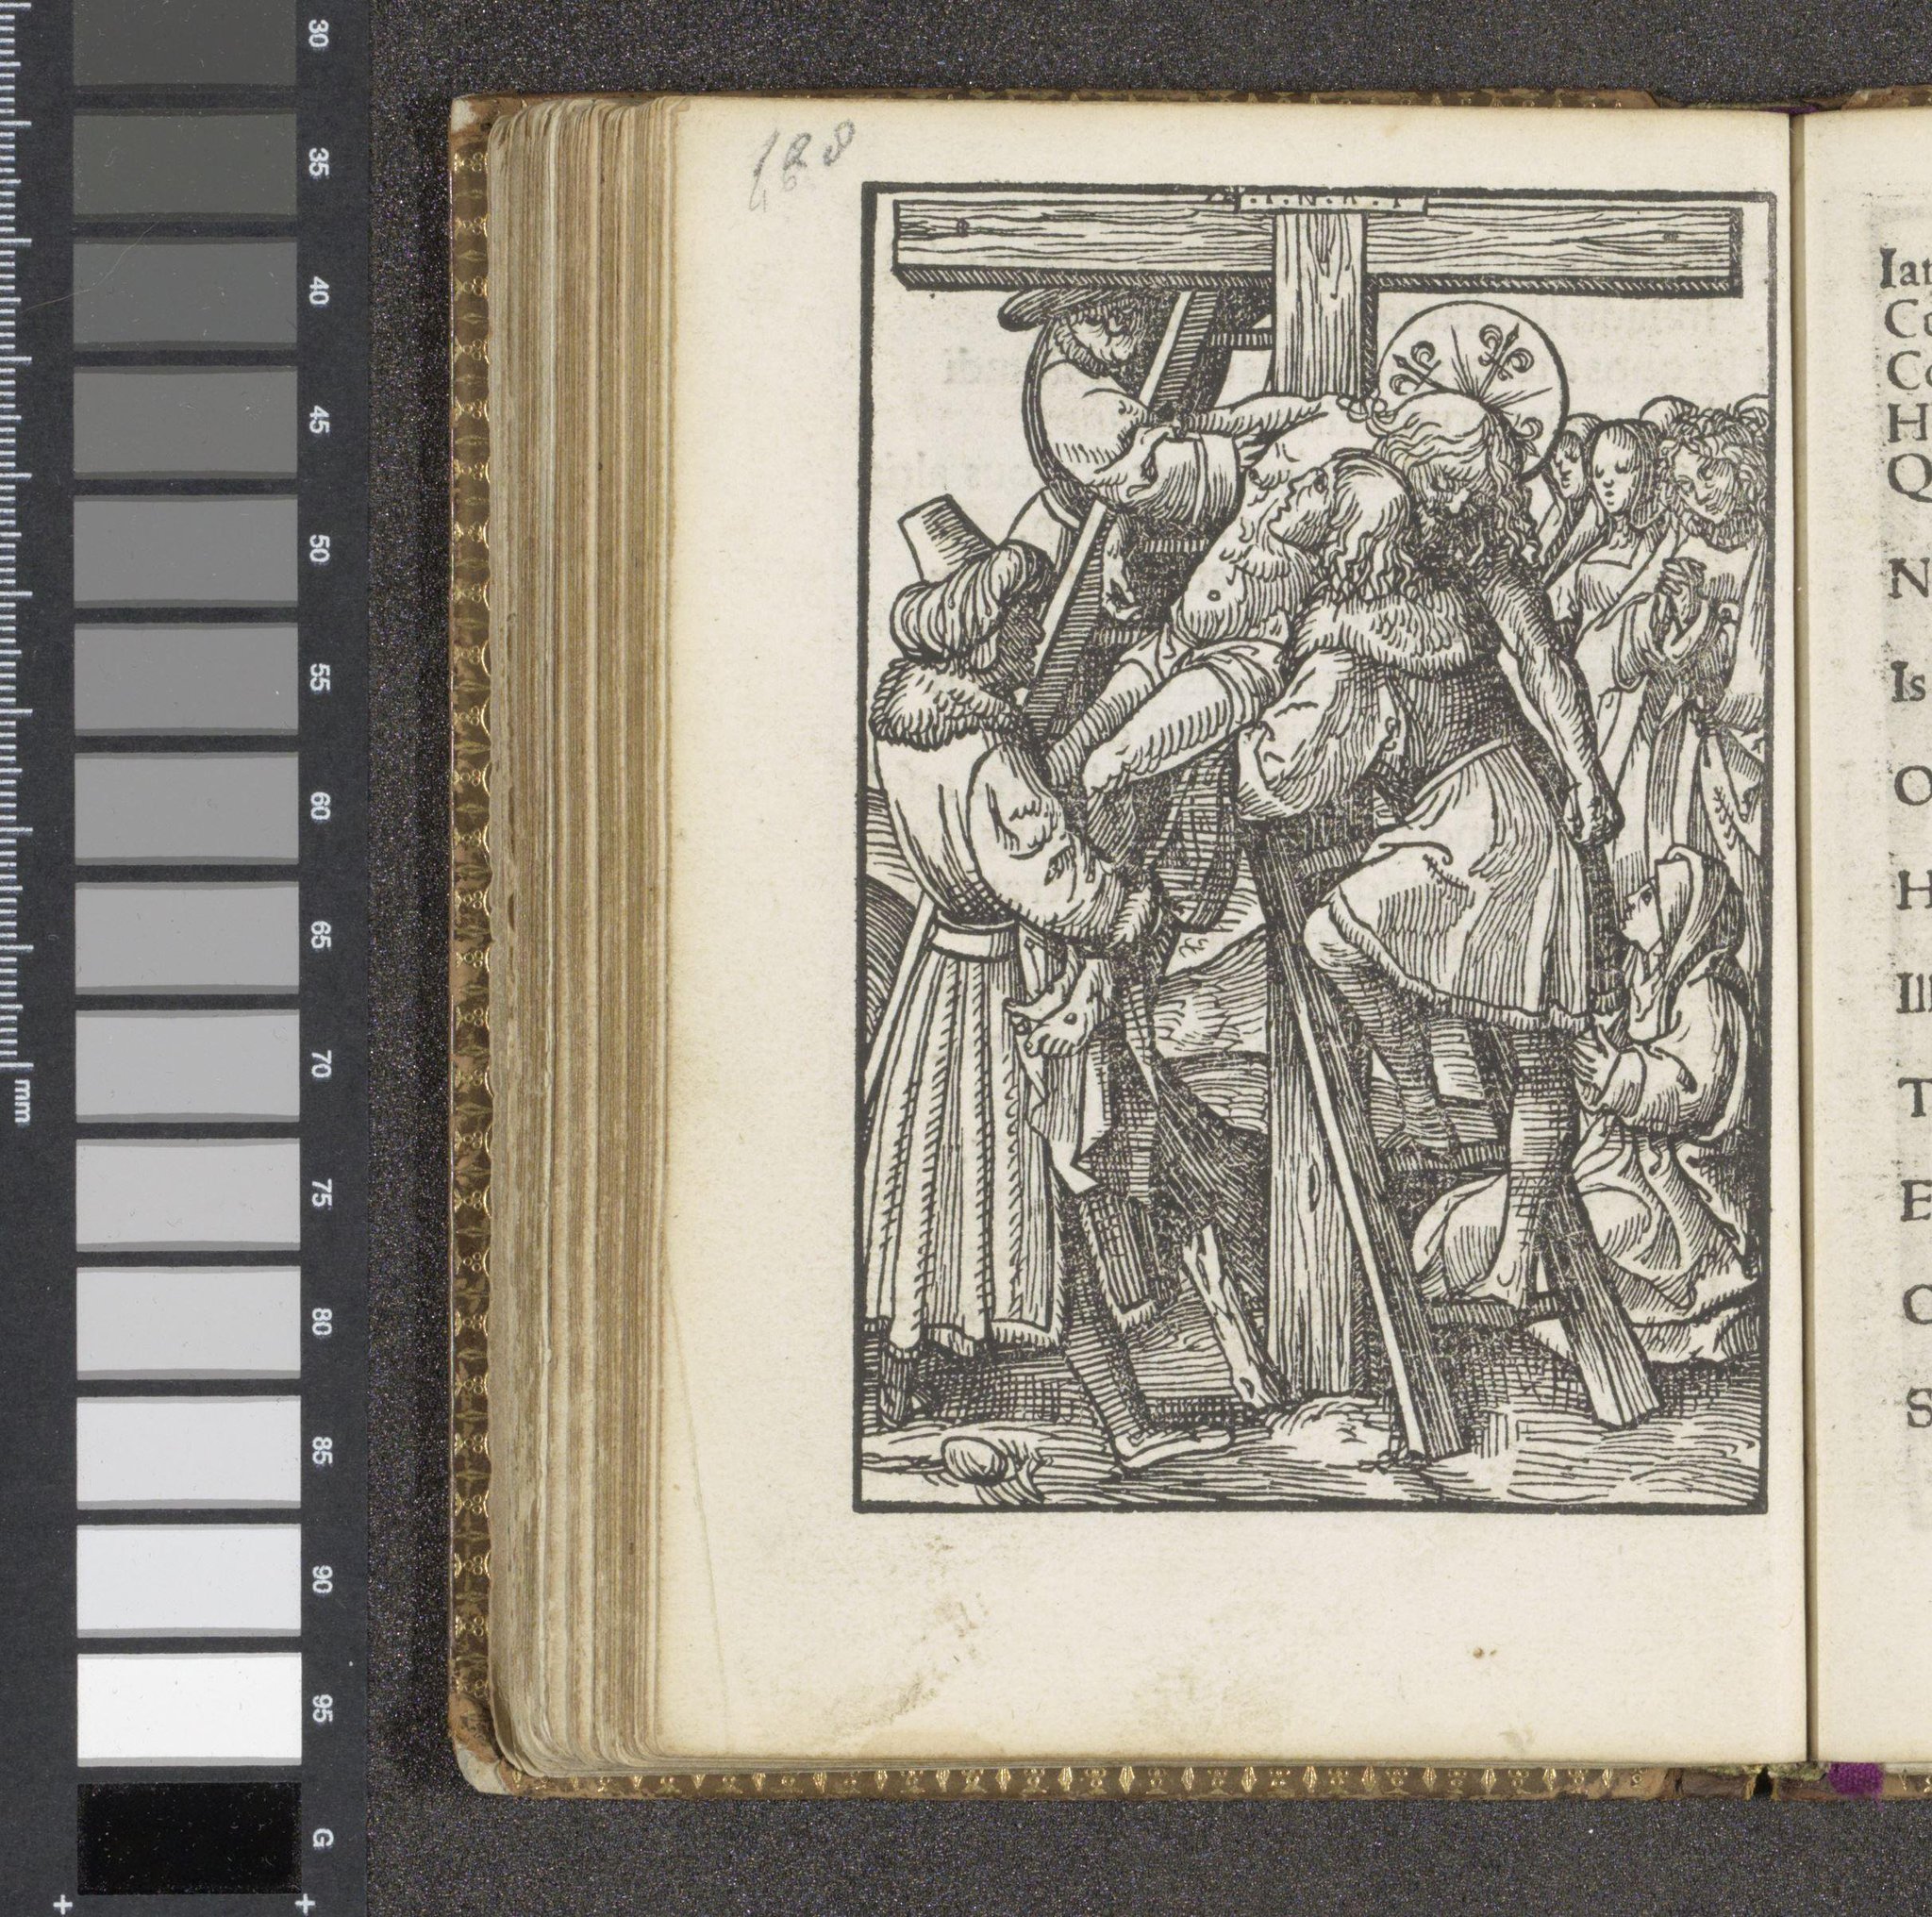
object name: print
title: Kruisafneming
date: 1523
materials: paper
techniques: woodcut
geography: amsterdam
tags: descent from the cross: christ is taken down from the cross, usually by nicodemus and joseph of arimathaea who are standing on the ladders (both arms of christ detached)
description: Het lichaam van Christus wordt van het kruis genomen. Prent maakt deel uit van een boek.